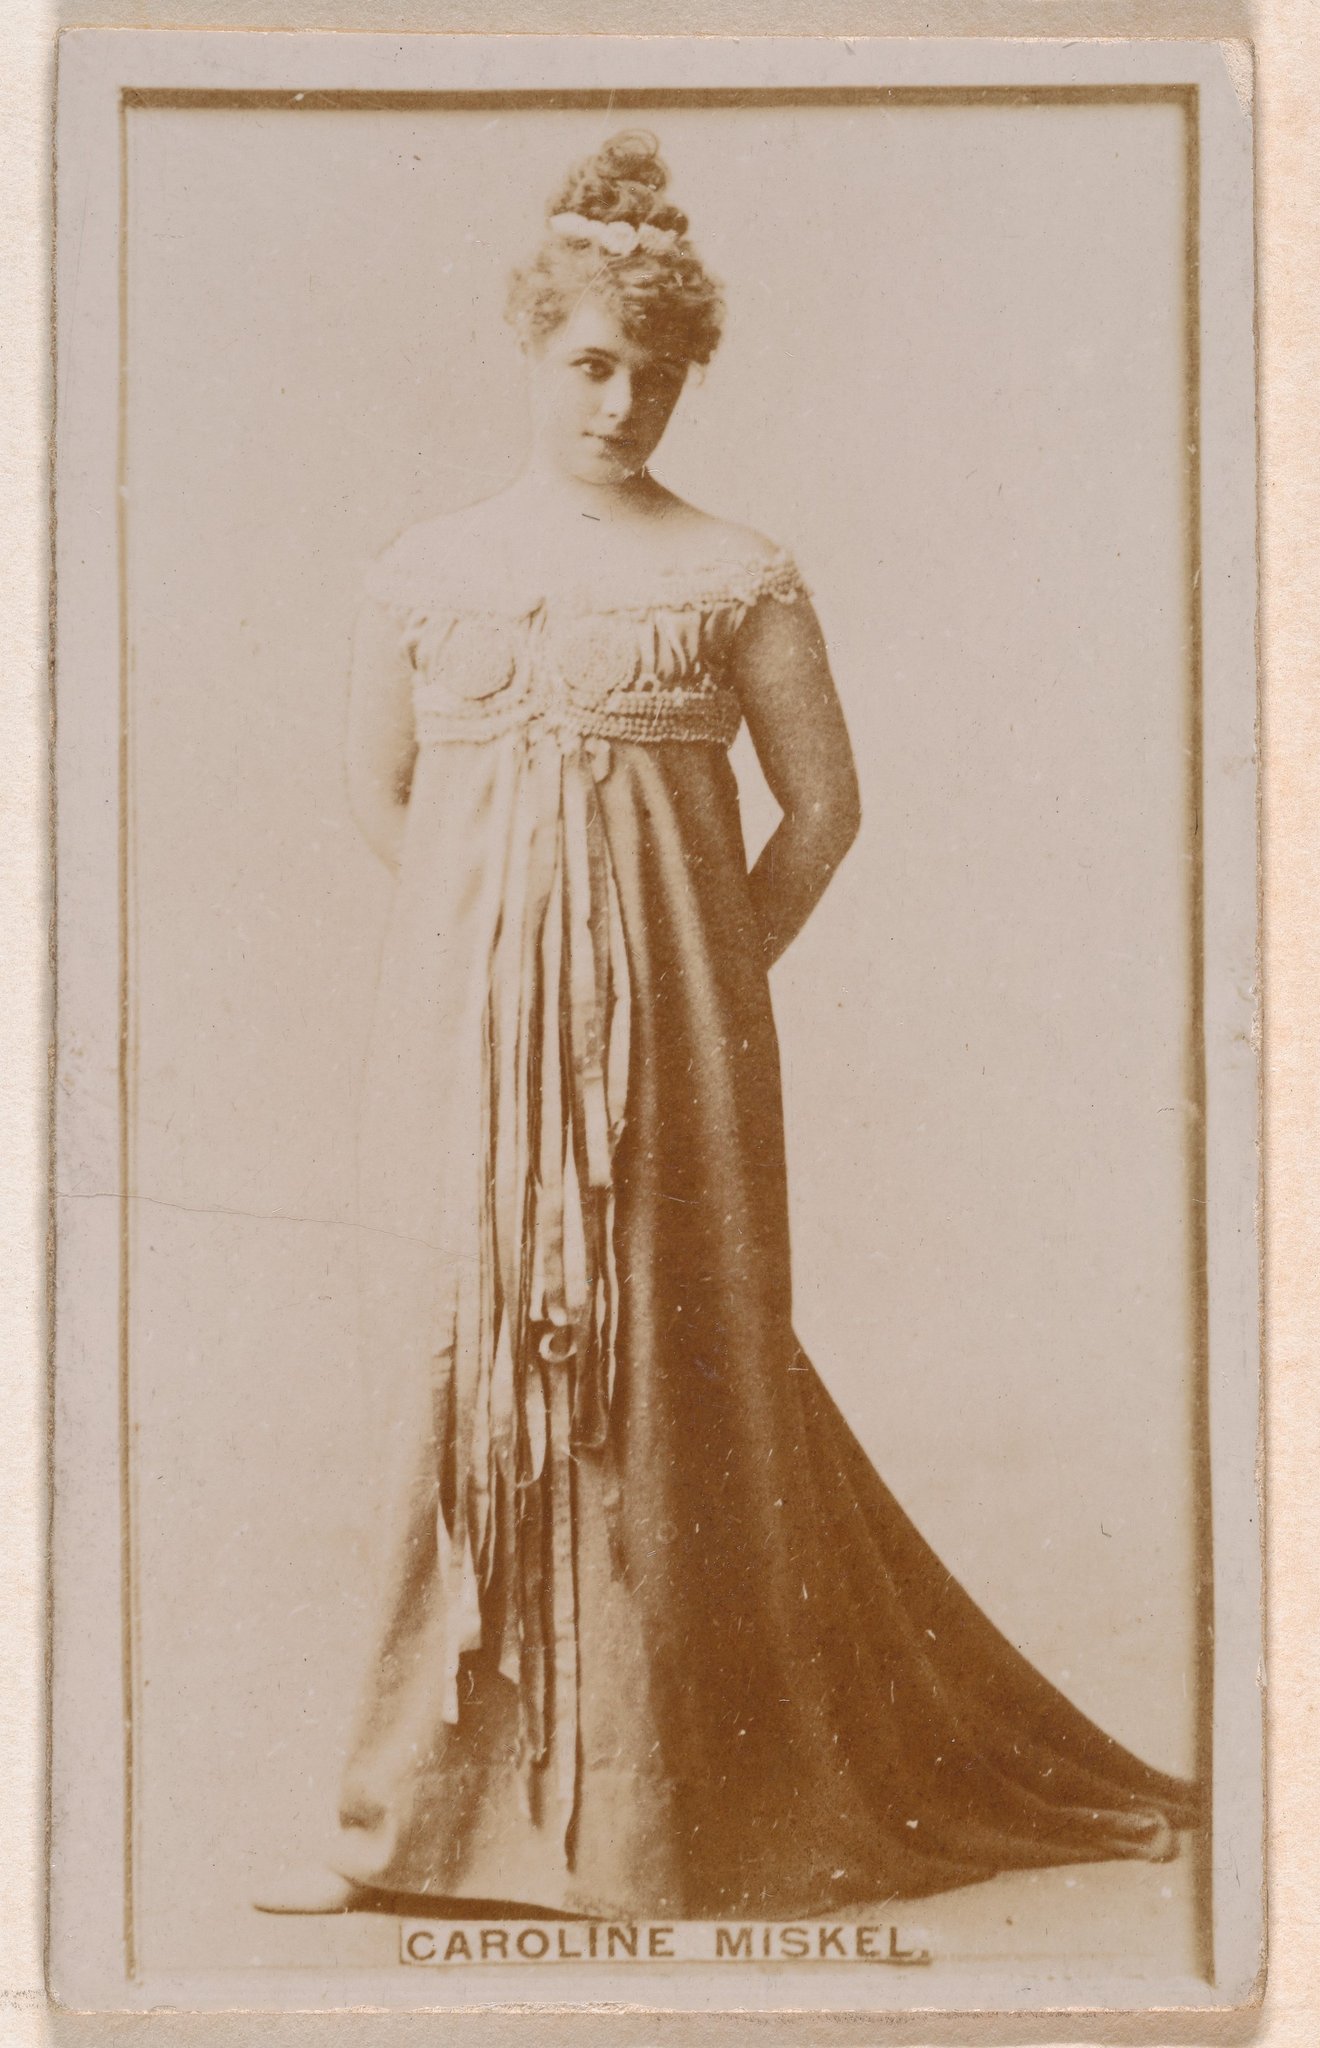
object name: photograph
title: Caroline Miskel, from the Actresses series (N245) issued by Kinney Brothers to promote Sweet Caporal Cigarettes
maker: kinney brothers tobacco company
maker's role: publisher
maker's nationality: american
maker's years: 1869-2011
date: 1890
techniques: albumen silver print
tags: portraits,women,actresses